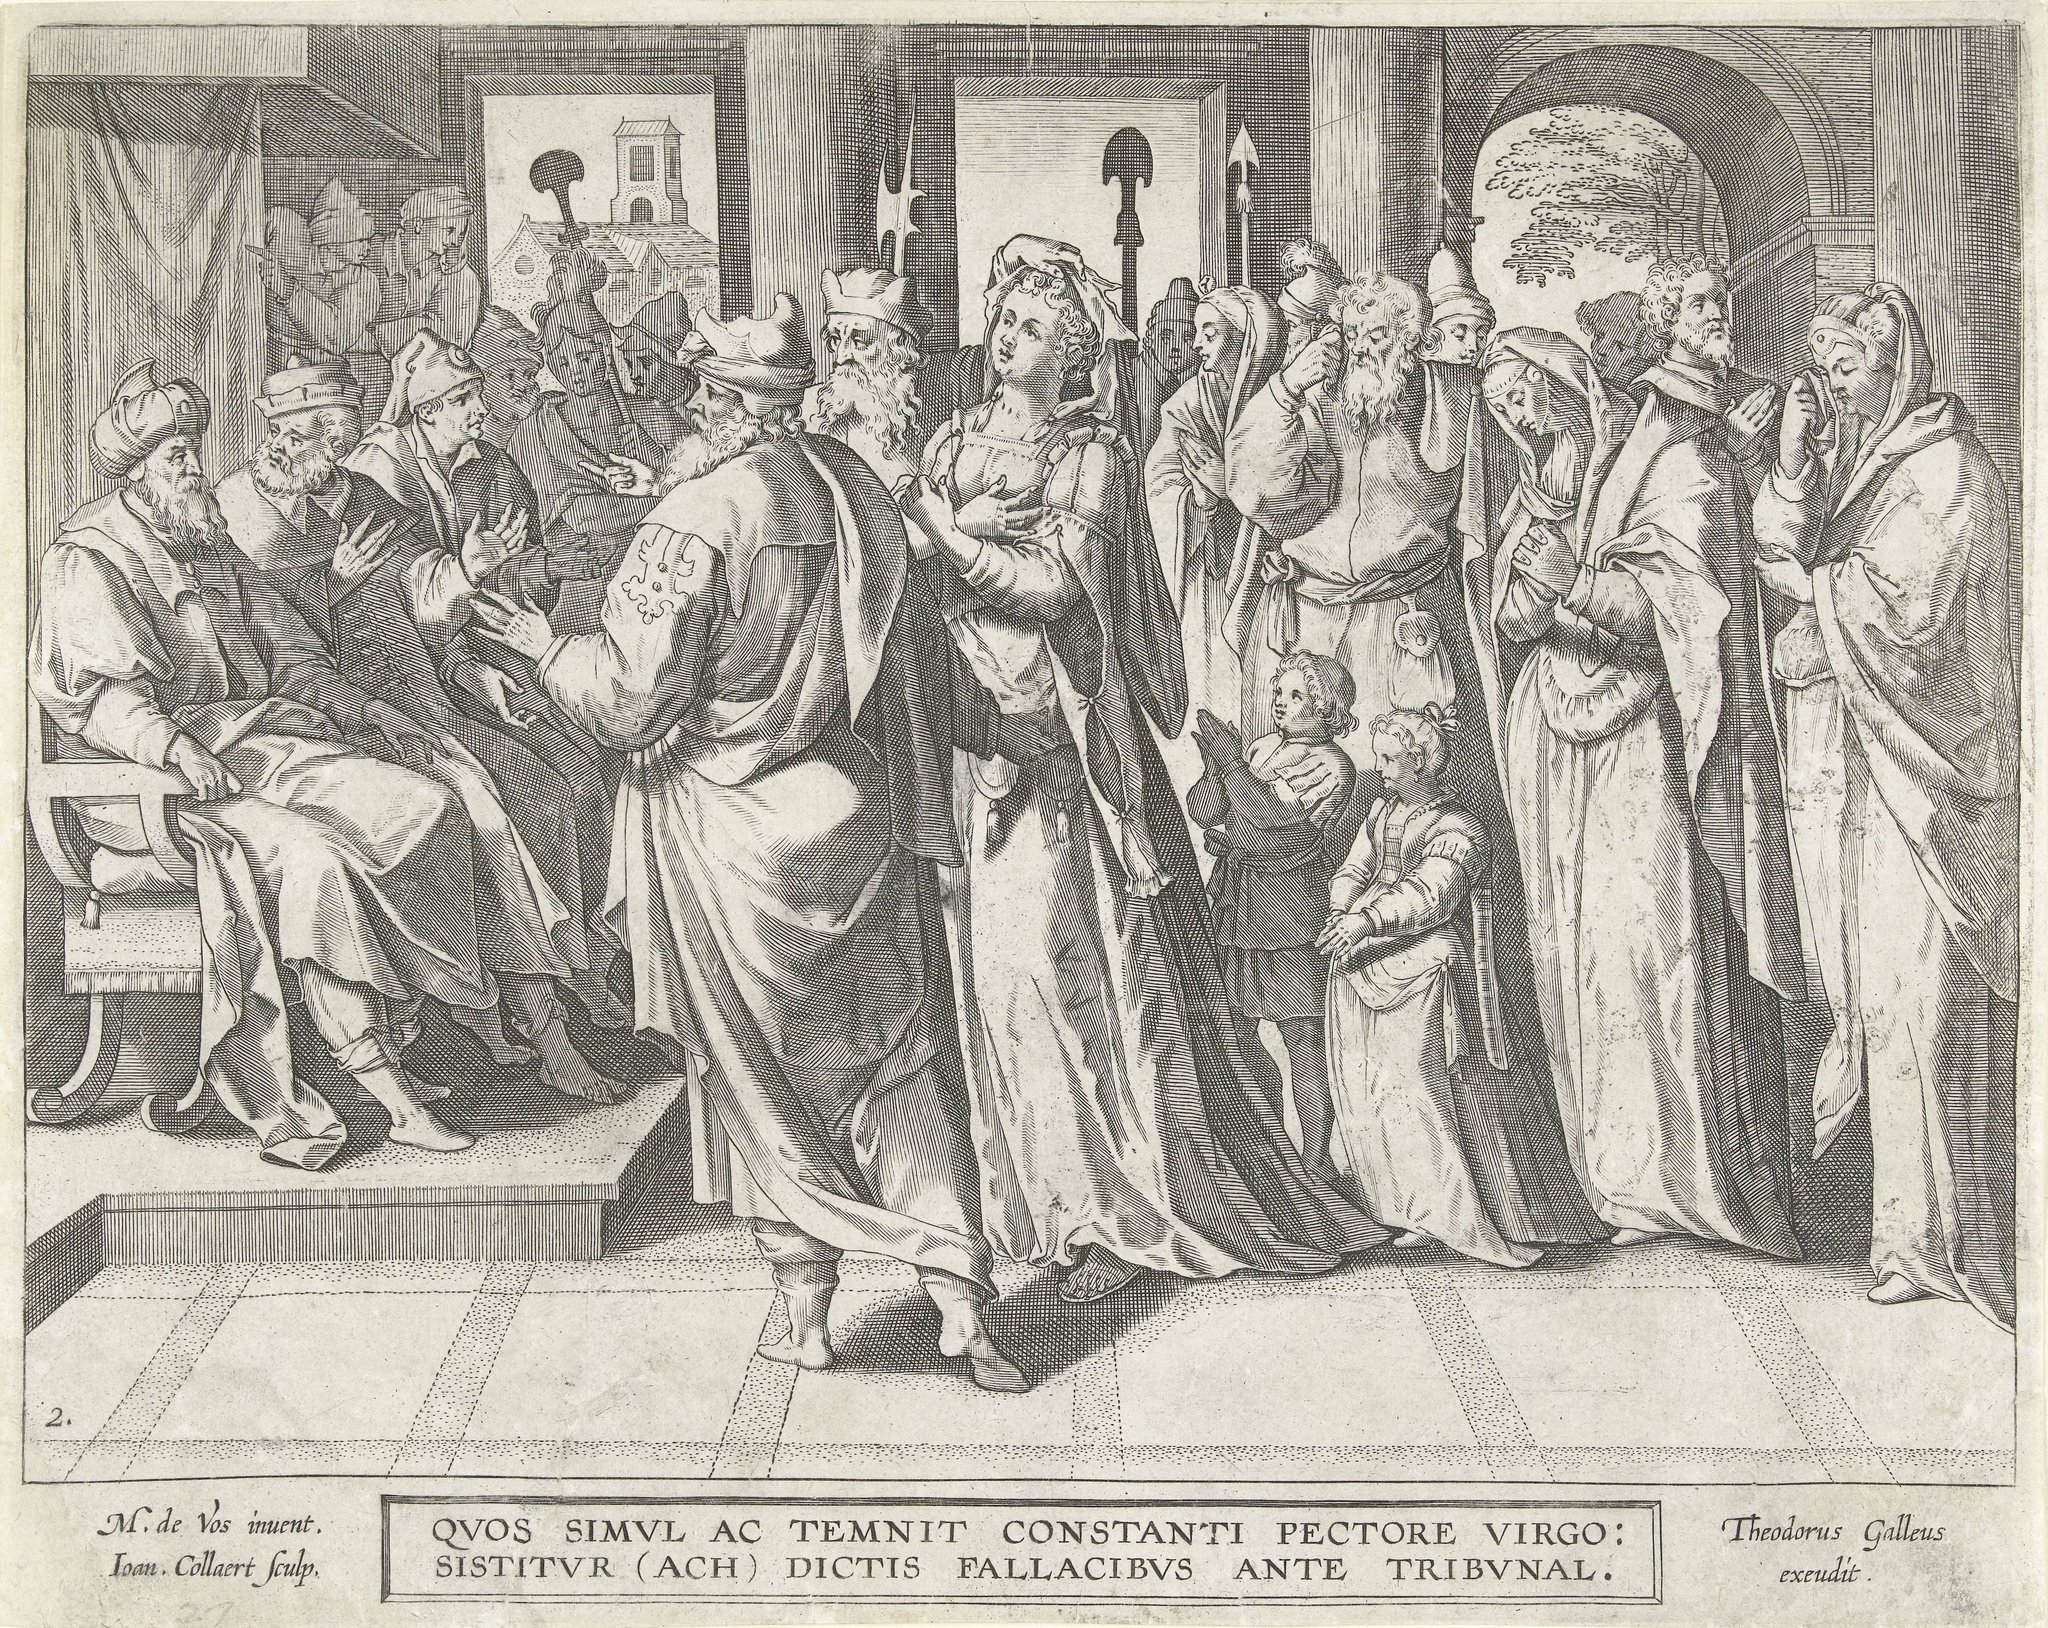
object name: print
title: Susanna voor de rechters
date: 1581-1633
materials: paper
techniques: engraving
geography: antwerp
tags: the elders accusing susanna before the people, laying their hands on her head or unveiling her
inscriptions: collector's mark: Lugt 2228, collector's mark: Lugt 2760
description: Susanna wordt voor de ouderlingen geleid, die haar beschuldigen van ontrouw. Als rechters veroordelen ze haar ook. De prent heeft een Latijns onderschrift en is deel van een serie met het verhaal van Susanna